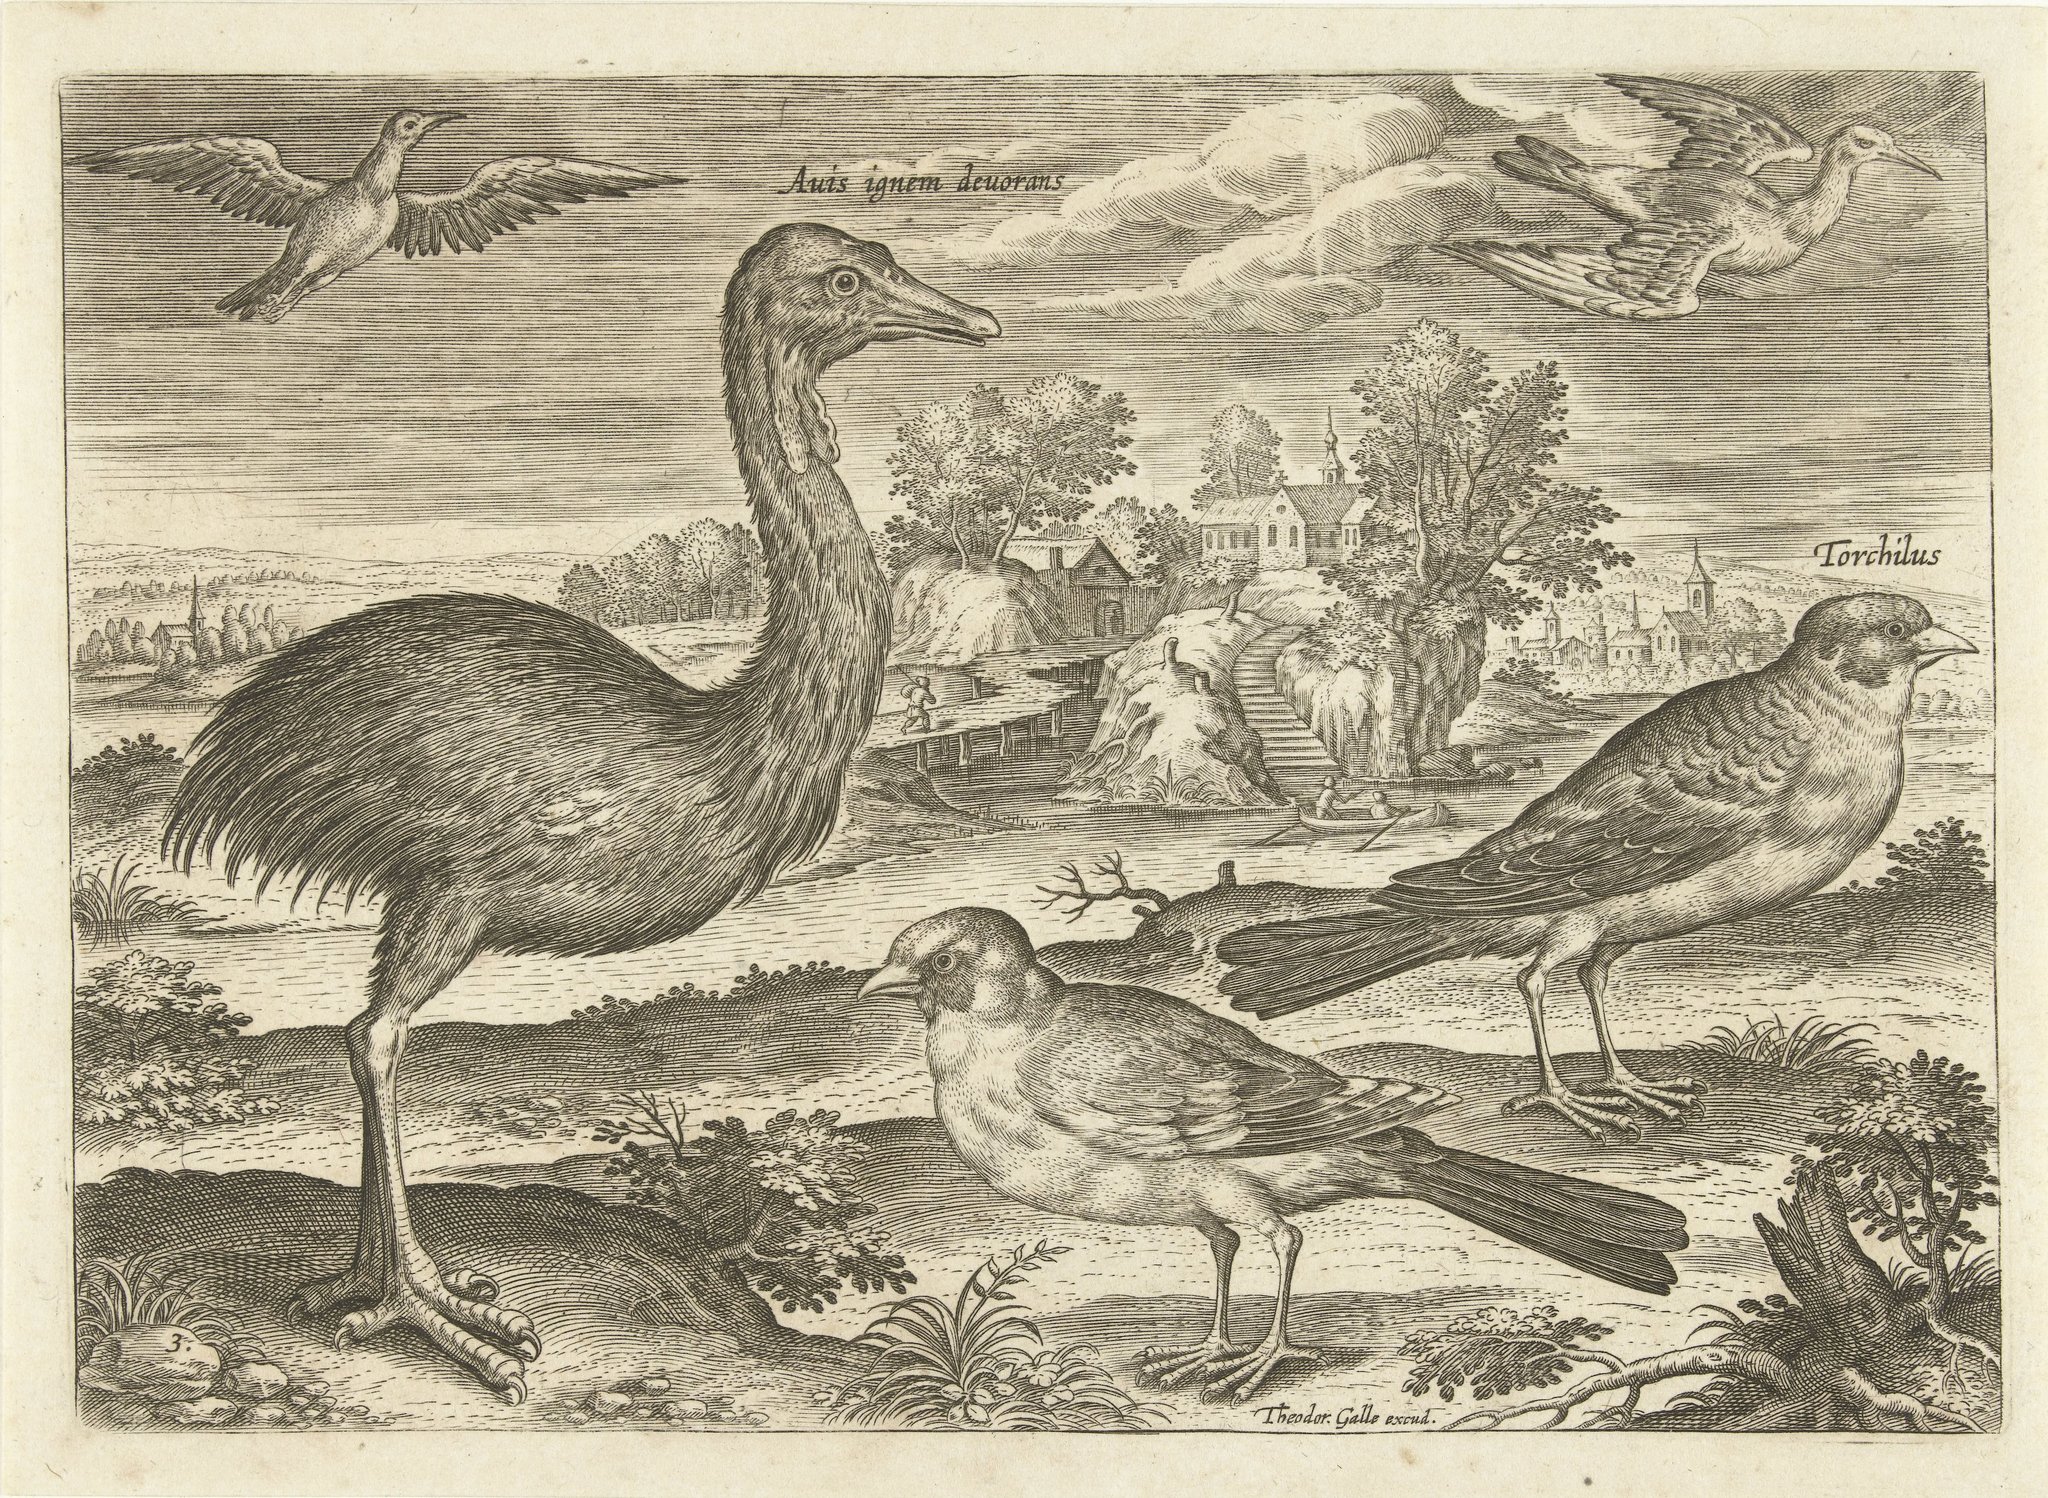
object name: print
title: Vogels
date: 1598-1618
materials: paper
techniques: engraving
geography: antwerp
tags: birds, song-birds: finch, lake (+ landscape with figures, staffage), walker and runner birds: rhea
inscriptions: collector's mark: Lugt 2228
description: Een nandoe, enkele vinken en twee andere vogels in een landschap met een vijver. De prent maakt deel uit van een serie met vogels als onderwerp.